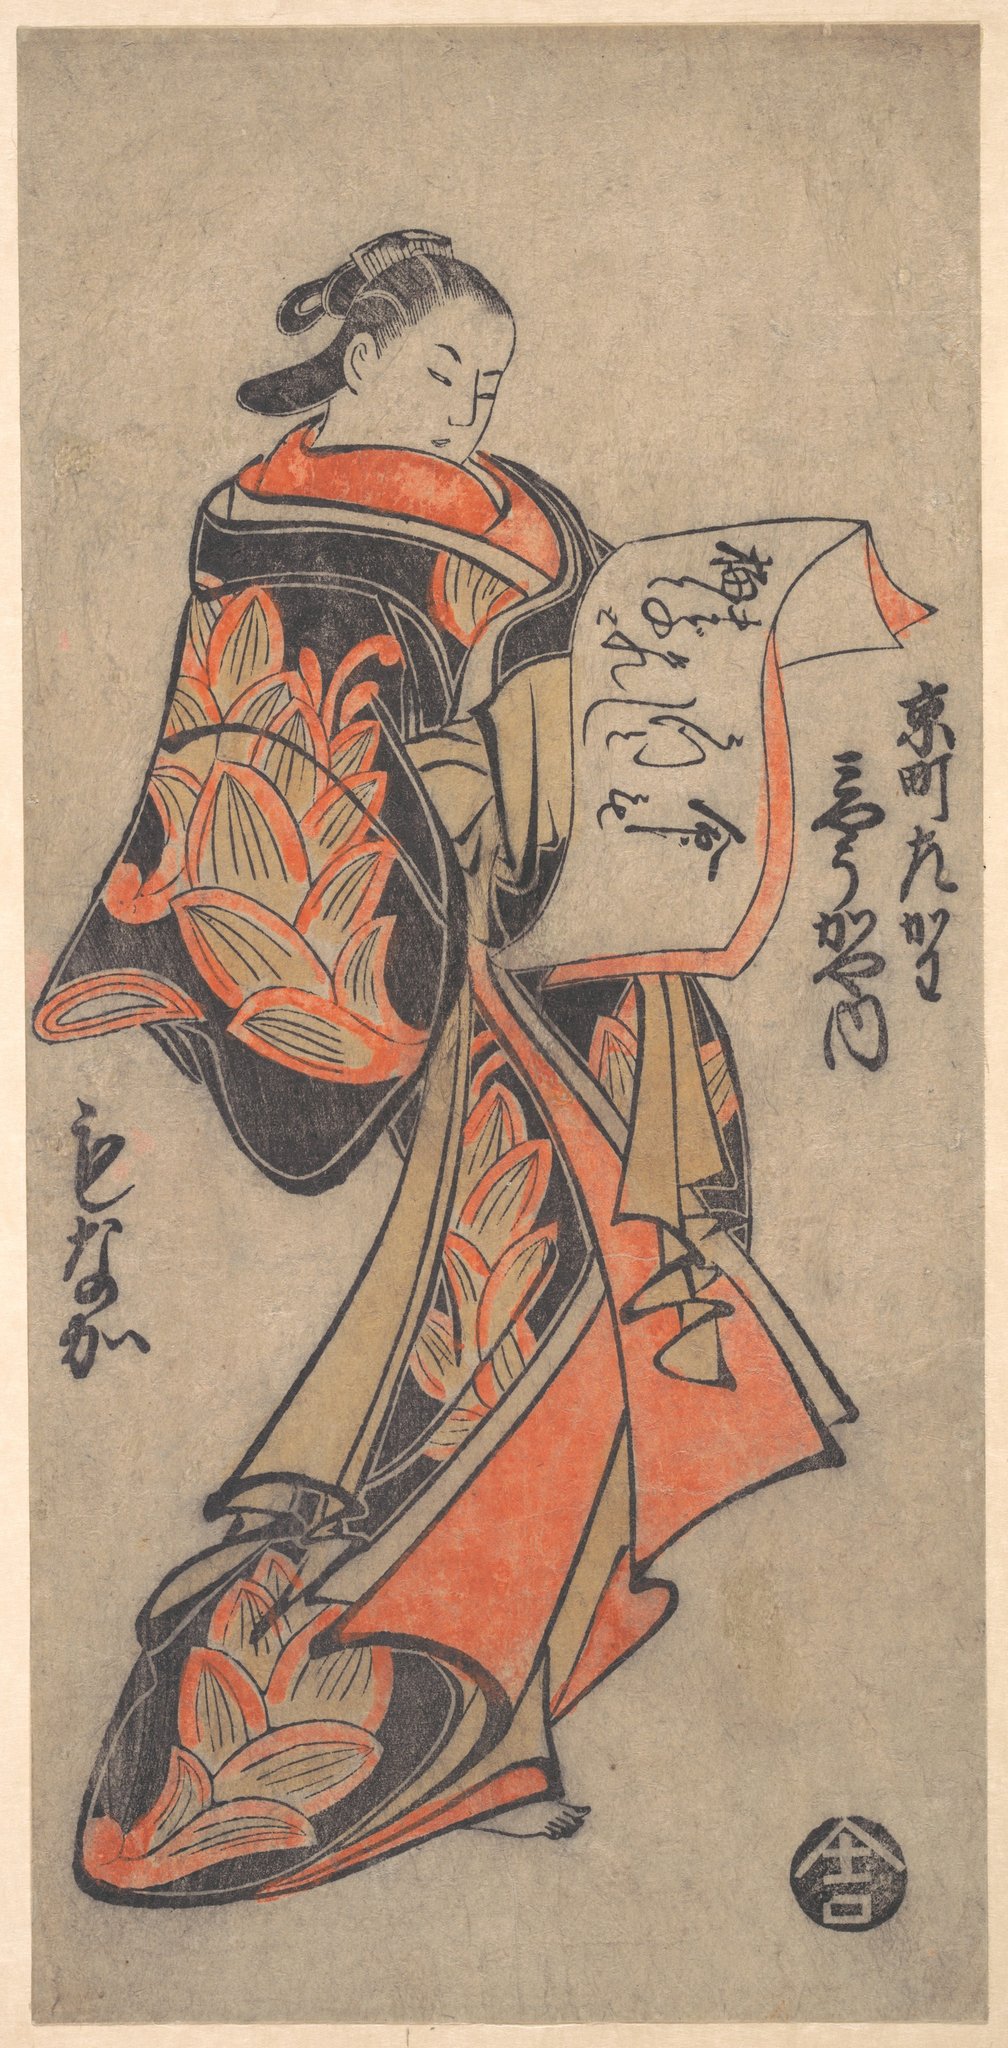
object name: print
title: Courtesan from the Myōgaya House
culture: japanese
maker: torii kiyomasu i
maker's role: artist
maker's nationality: japanese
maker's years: 1696-1716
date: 1712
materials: ink, paper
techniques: woodblock print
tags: women